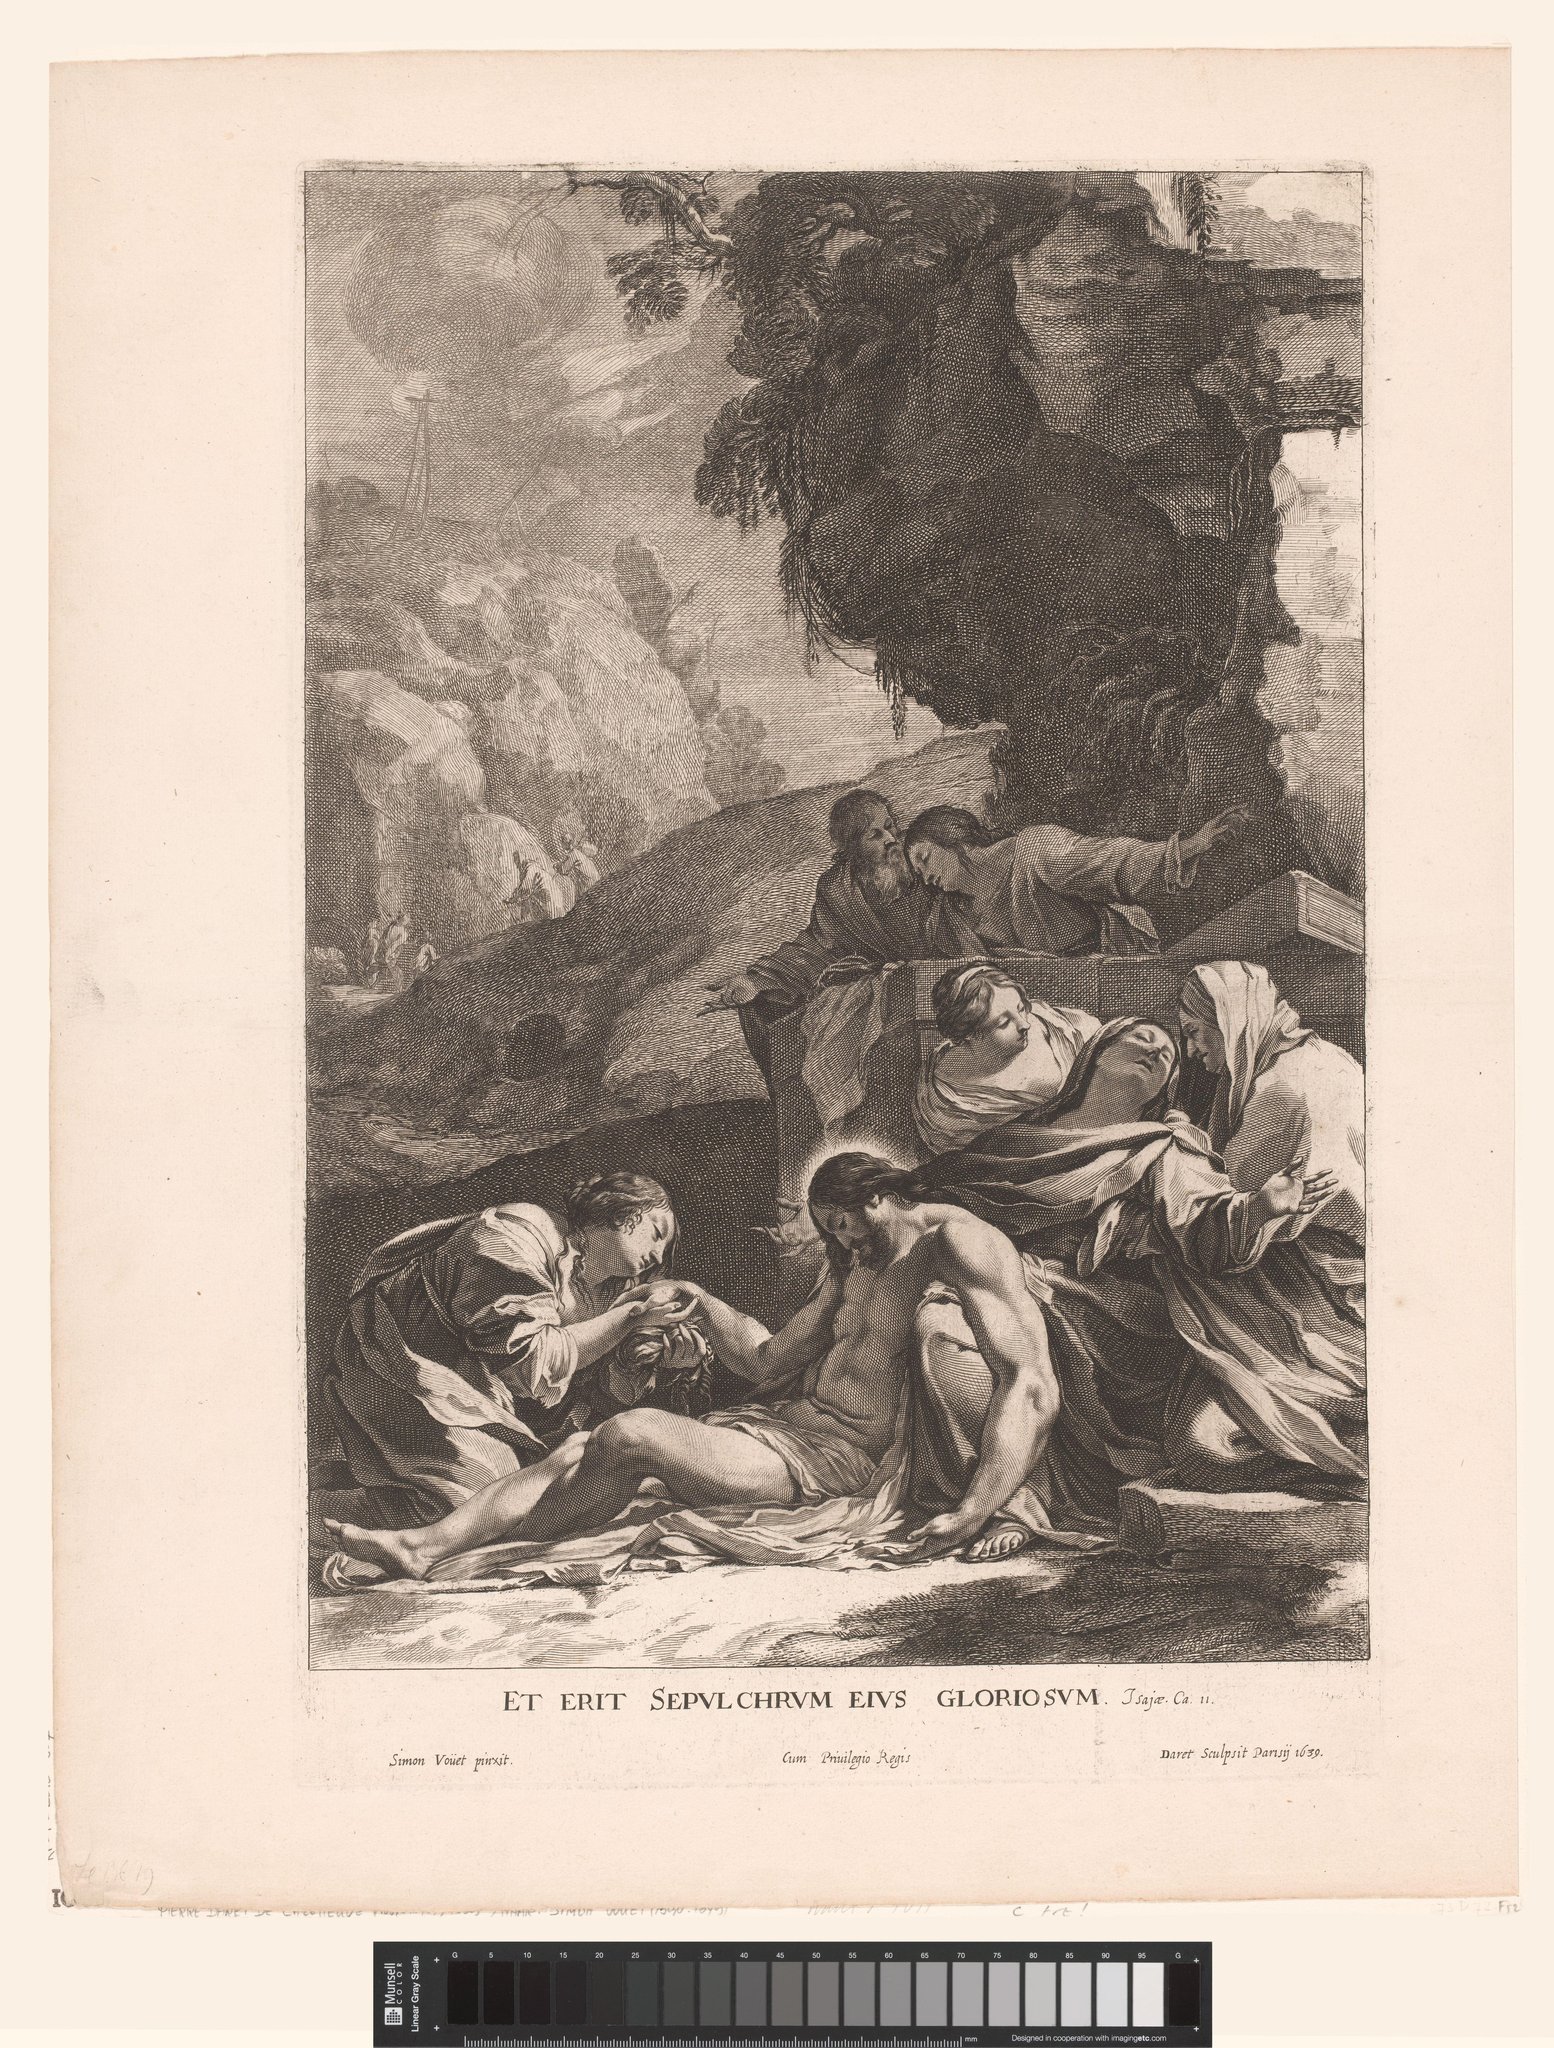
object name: print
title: Graflegging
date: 1639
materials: paper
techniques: engraving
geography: france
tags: preparations for christ's entombment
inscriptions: collector's mark: Lugt 2228